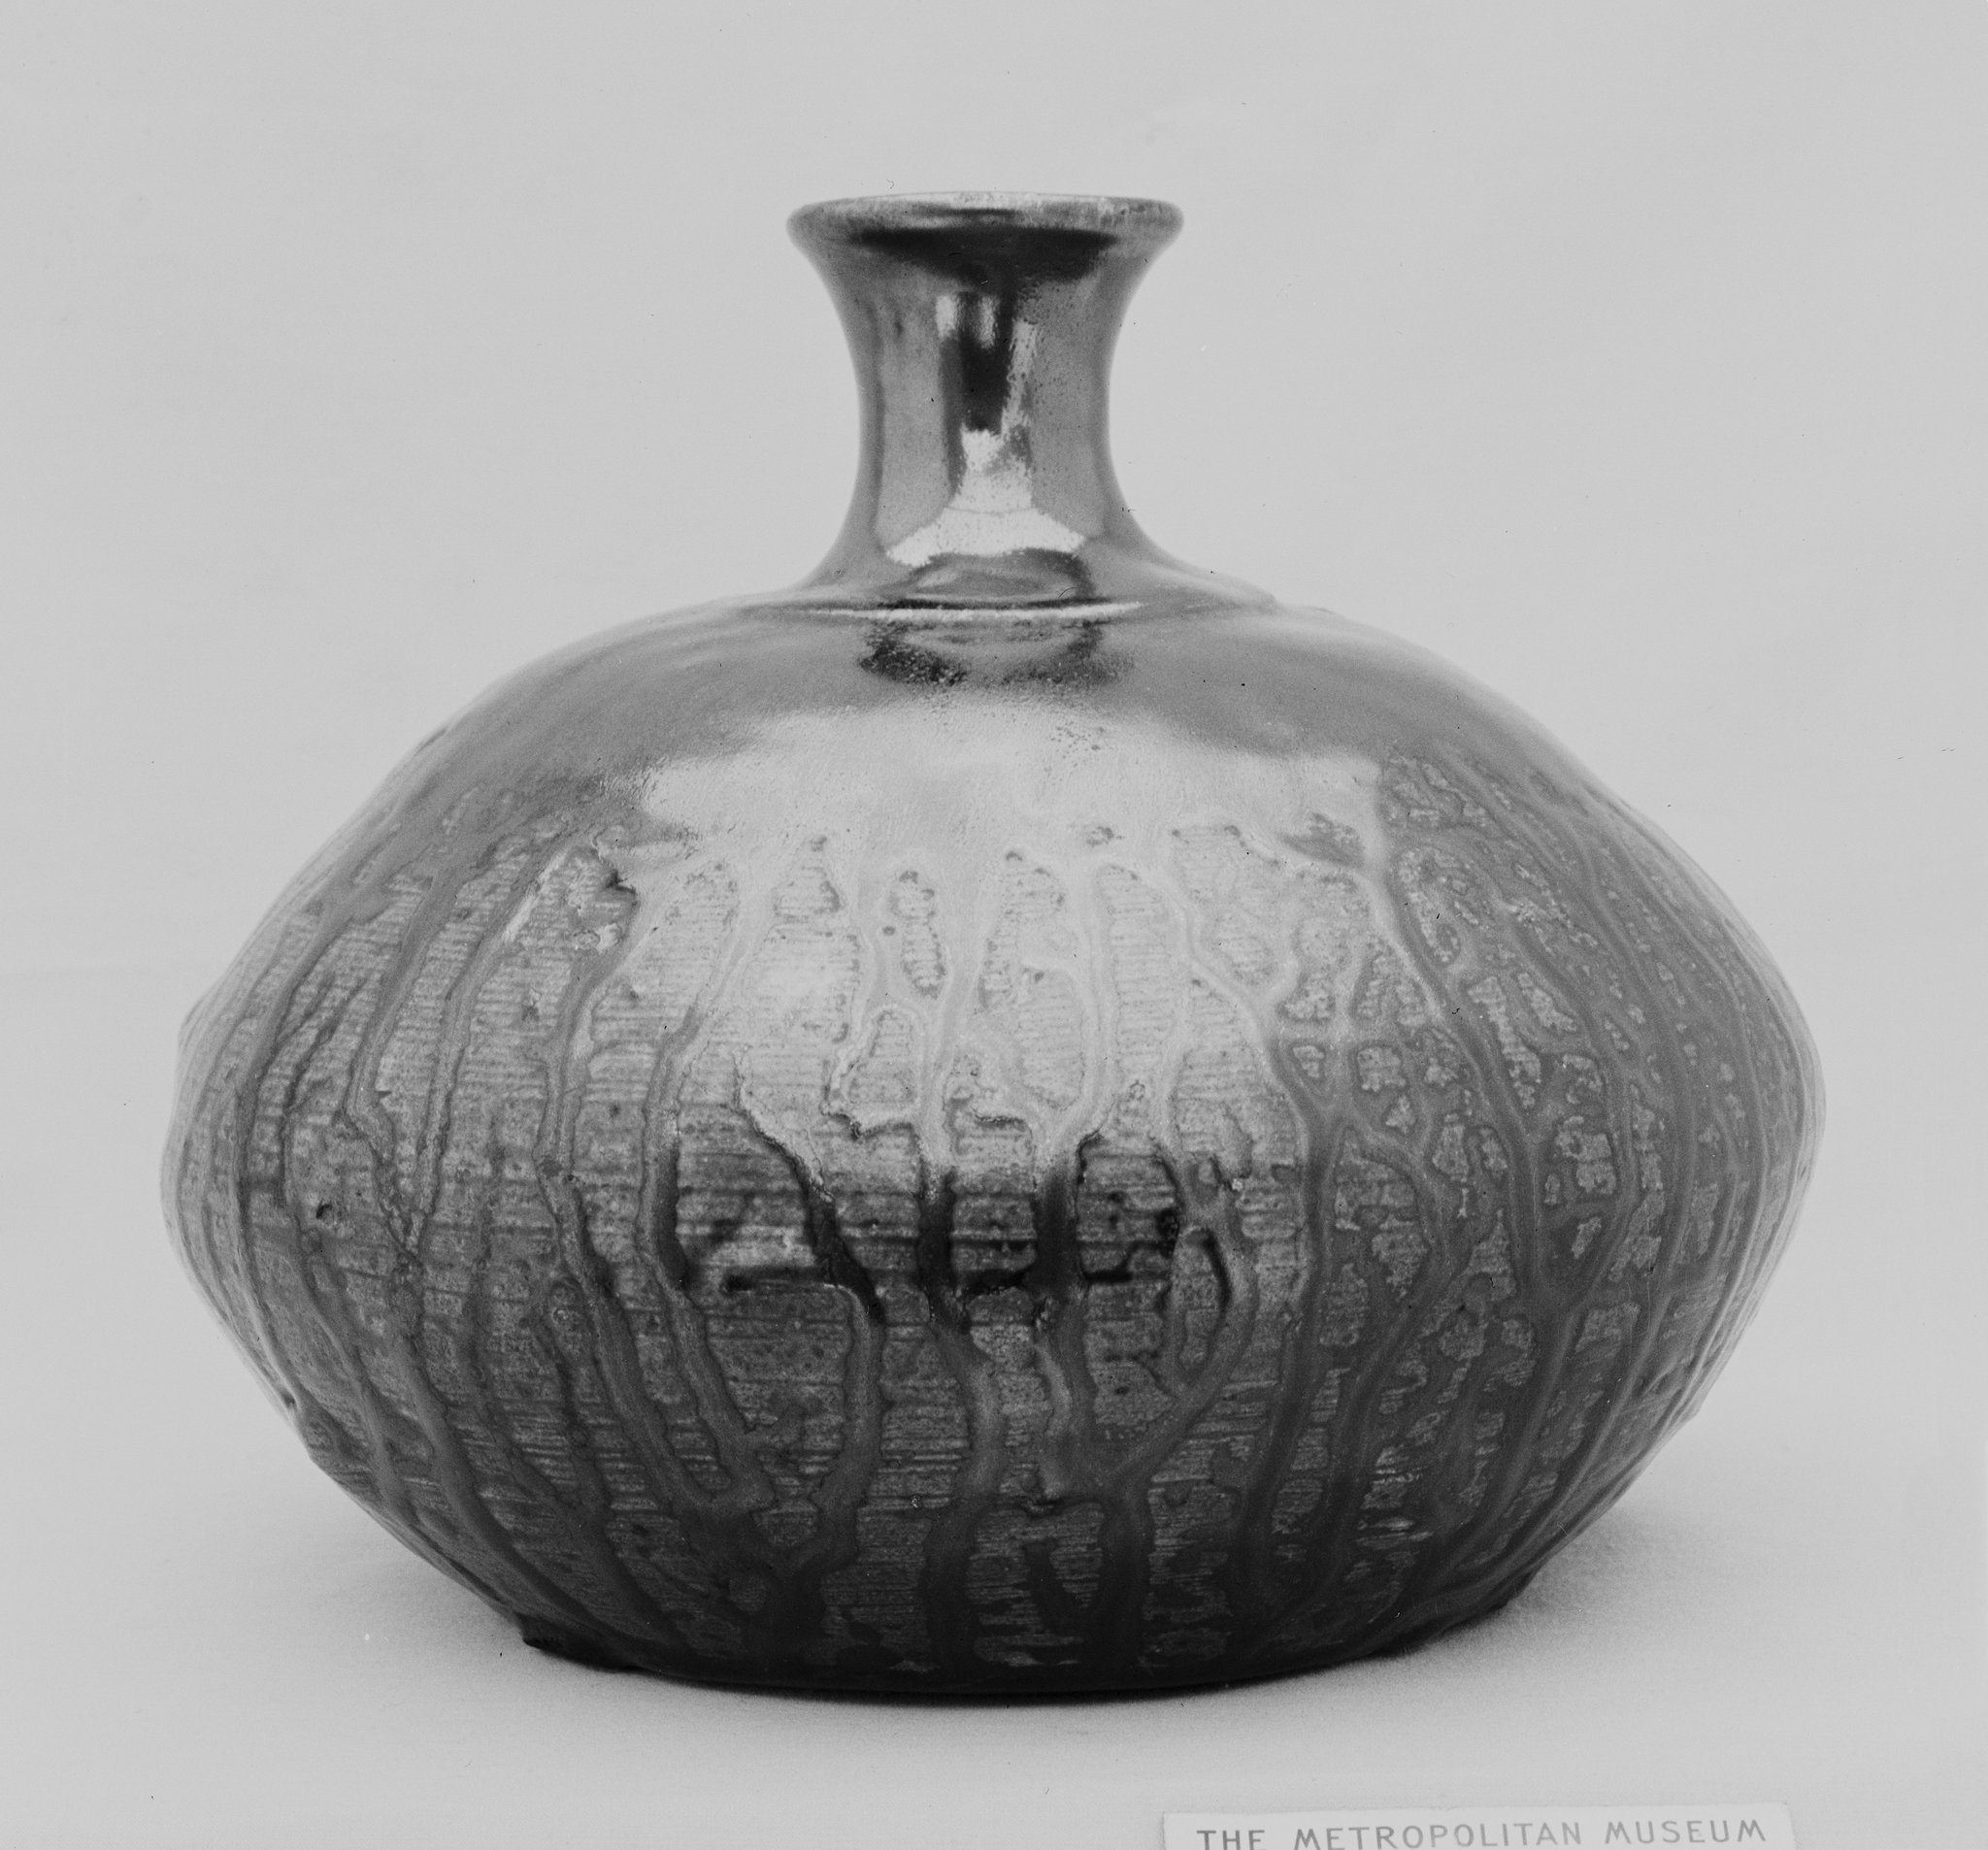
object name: wine bottle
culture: japanese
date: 1701-1800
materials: clay, glaze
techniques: overglaze